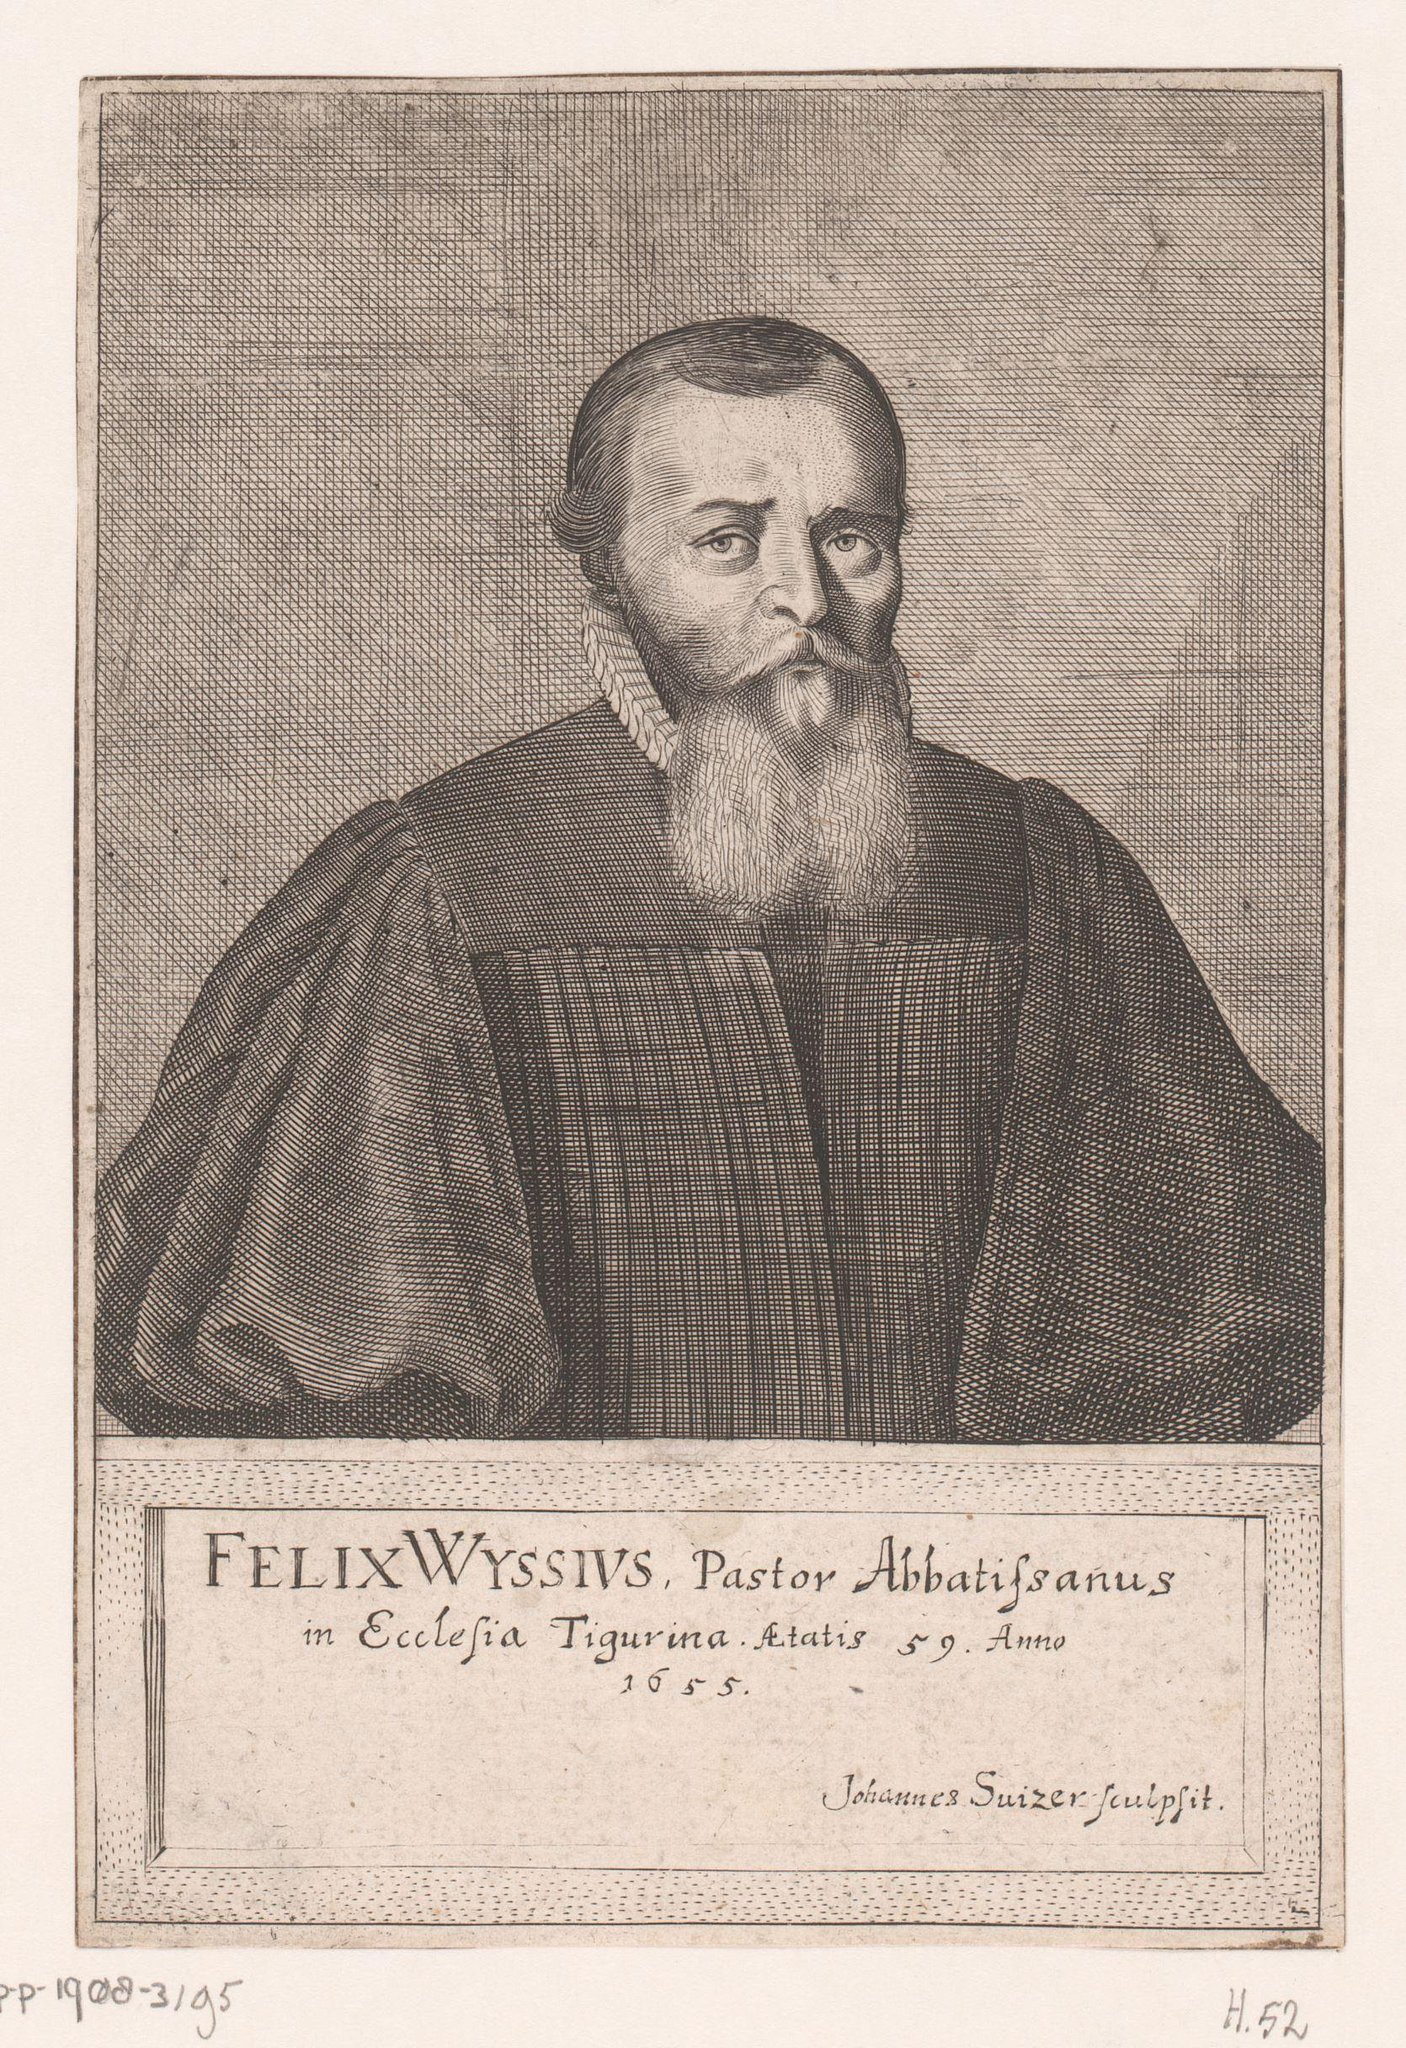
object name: print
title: Portret van Felix Wyss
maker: johann schweizer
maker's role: print maker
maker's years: 1625-1670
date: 1655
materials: paper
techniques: engraving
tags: theologian, historical persons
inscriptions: collector's mark: Lugt 2228